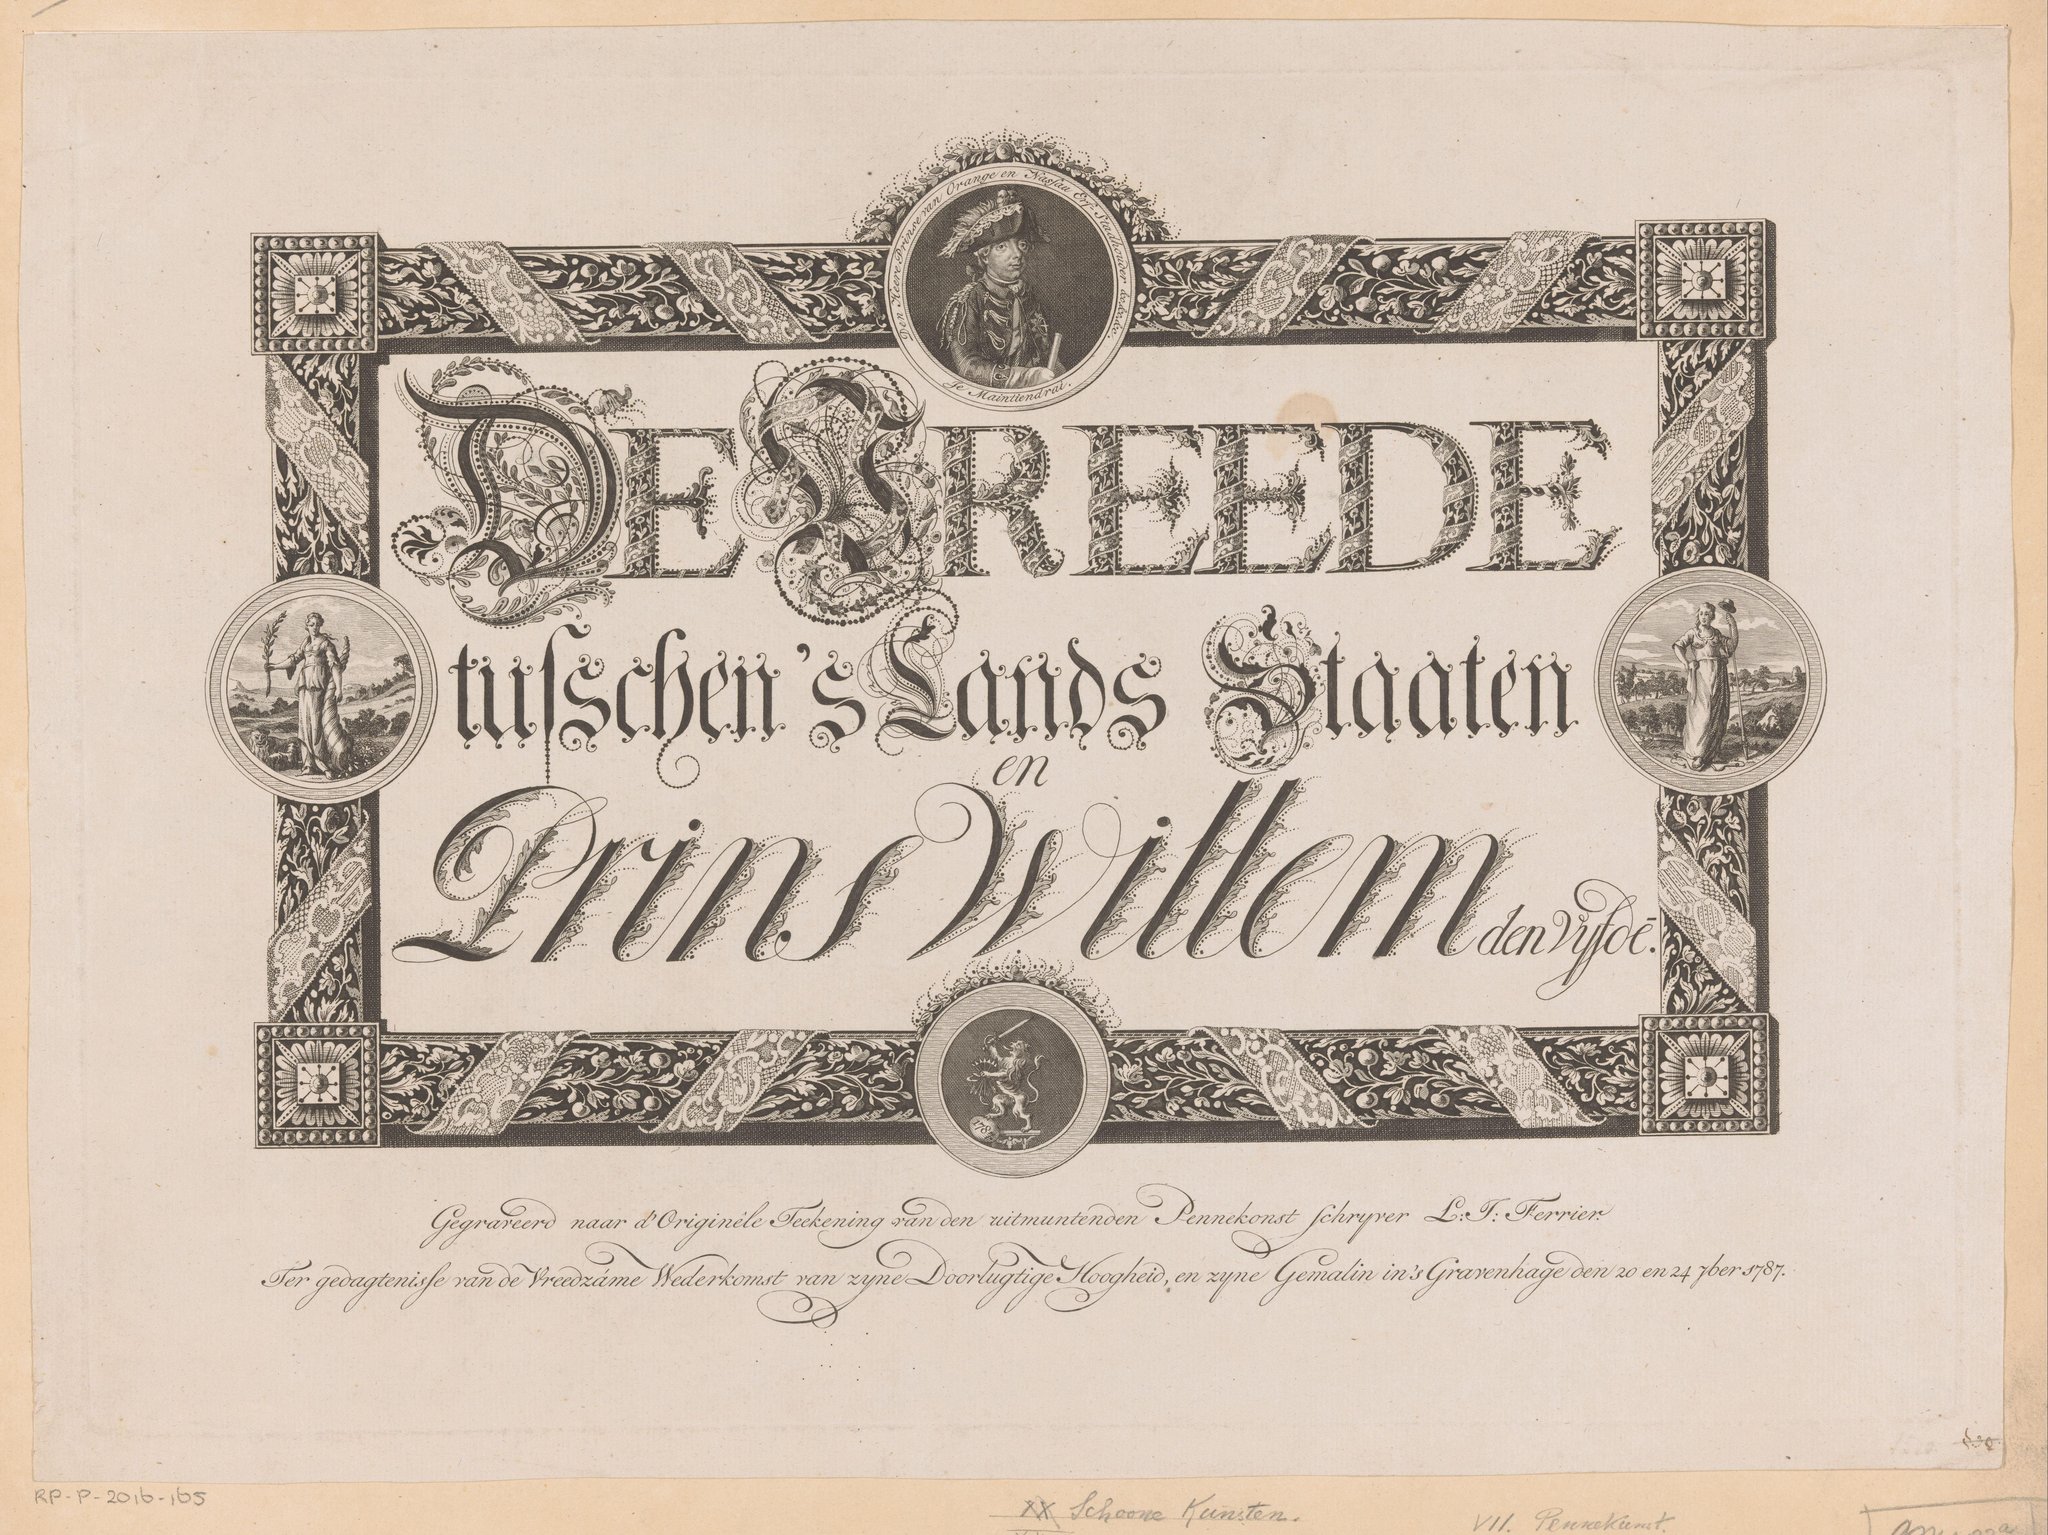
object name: print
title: De Vreede tusschen 's Lands Staaten en Prins Willem den Vyfde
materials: paper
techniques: engraving, etching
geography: northern netherlands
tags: calligraphy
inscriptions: collector's mark: Lugt 2228, collector's mark: Lugt 1641a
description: Kalligrafische allegorie op het herstel van de vrede tussen de Staten-Generaal en prins Willem V, ter gelegenheid van de inhaling van de prins en prinses van Oranje in Den Haag op 20 en 24 september 1787. Met twee allegorische medaillons met de Vrede en de Vrijheid, een portret van de prins en de Hollandse Leeuw. Onderaan een tweeregelig onderschrift.